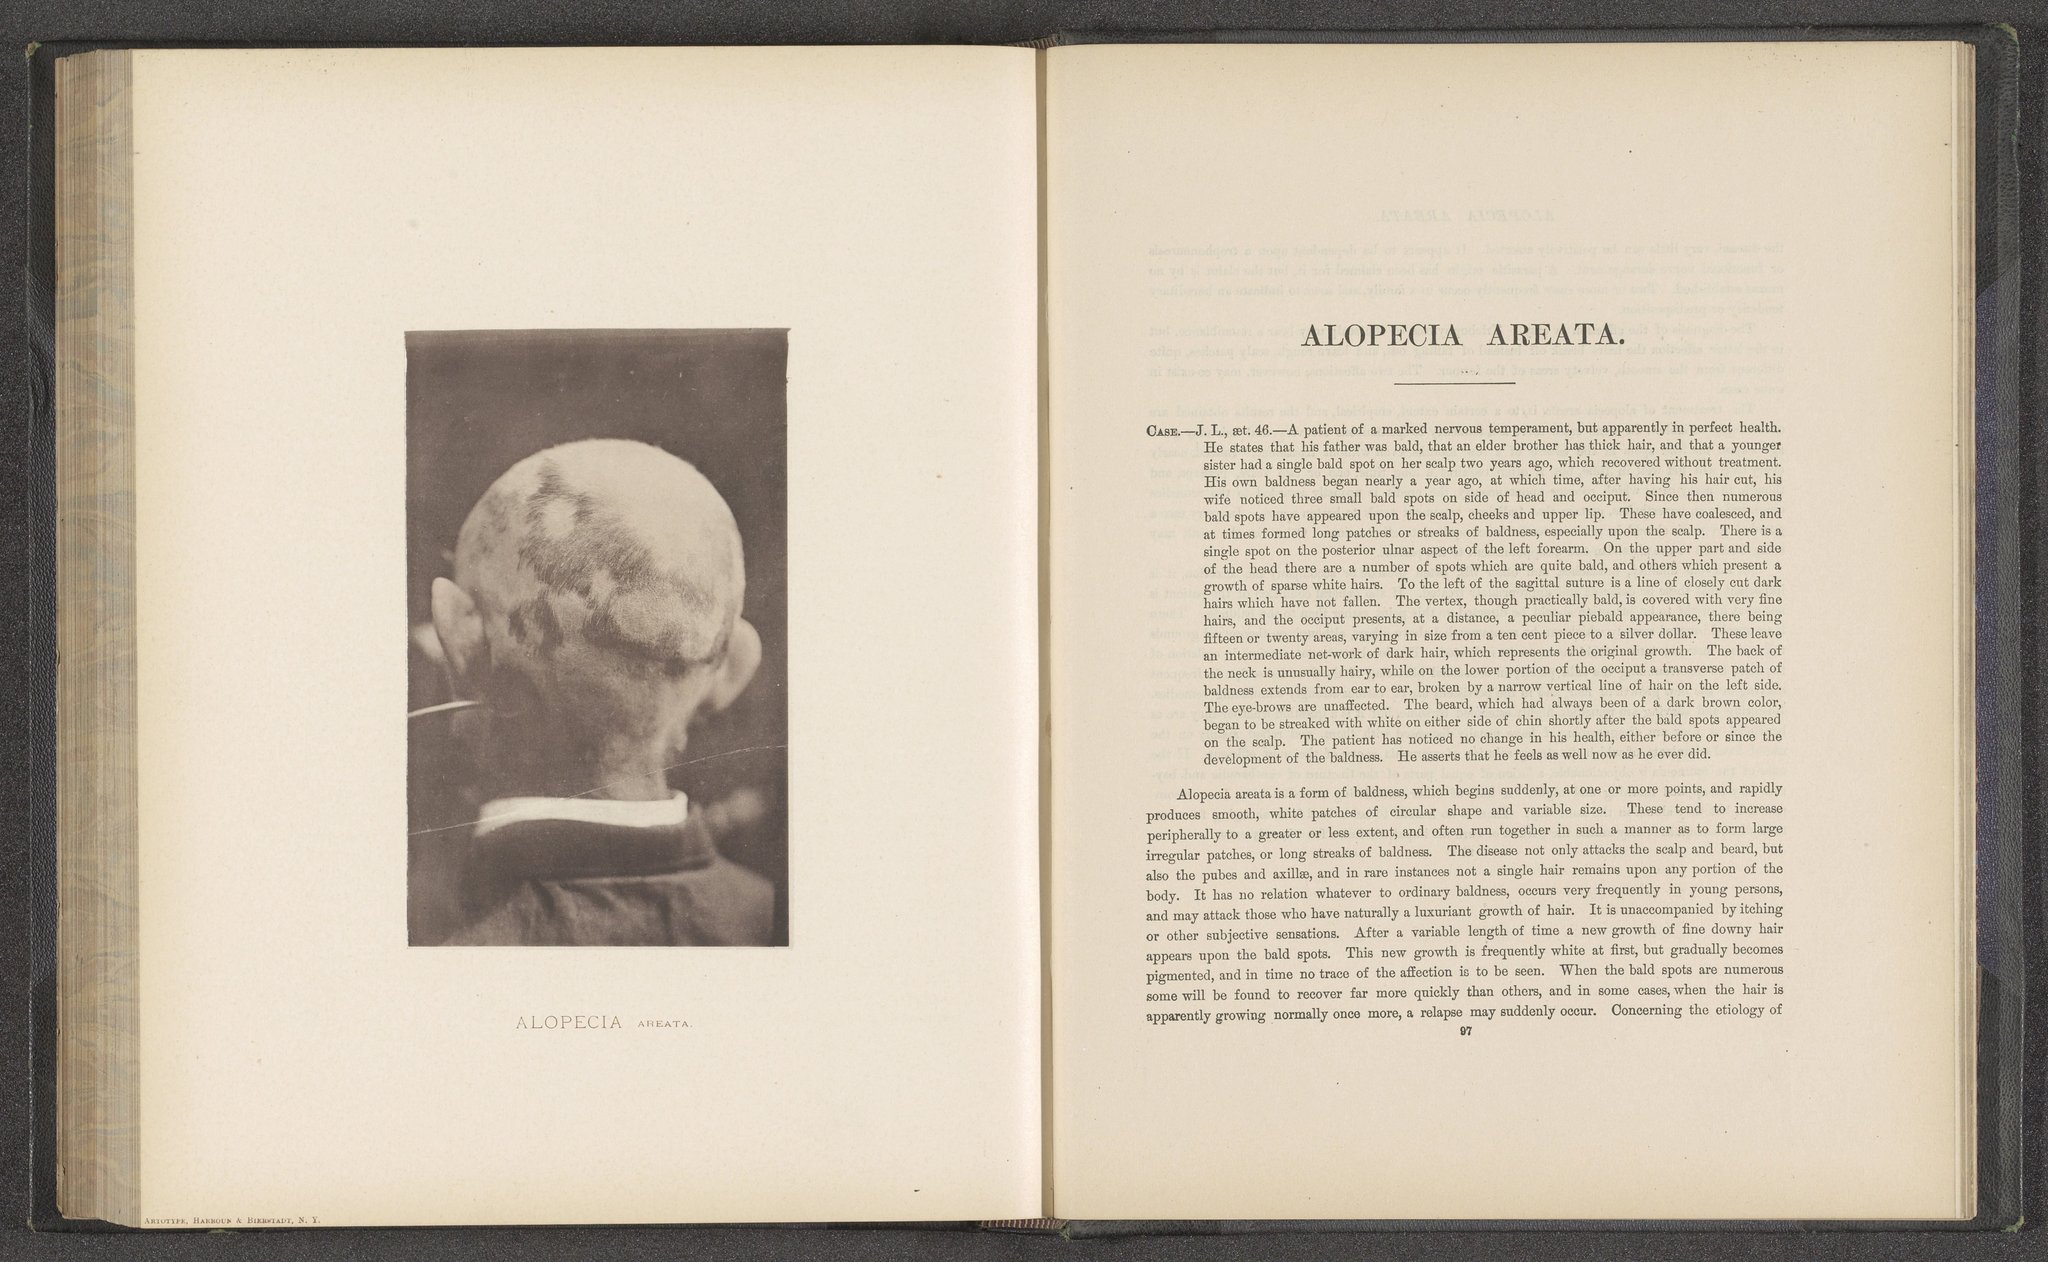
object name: page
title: Alopecia areata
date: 1870-1881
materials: paper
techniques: photograph, hand coloring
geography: new york city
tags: head (human), skin and venereal diseases, hair, adult man